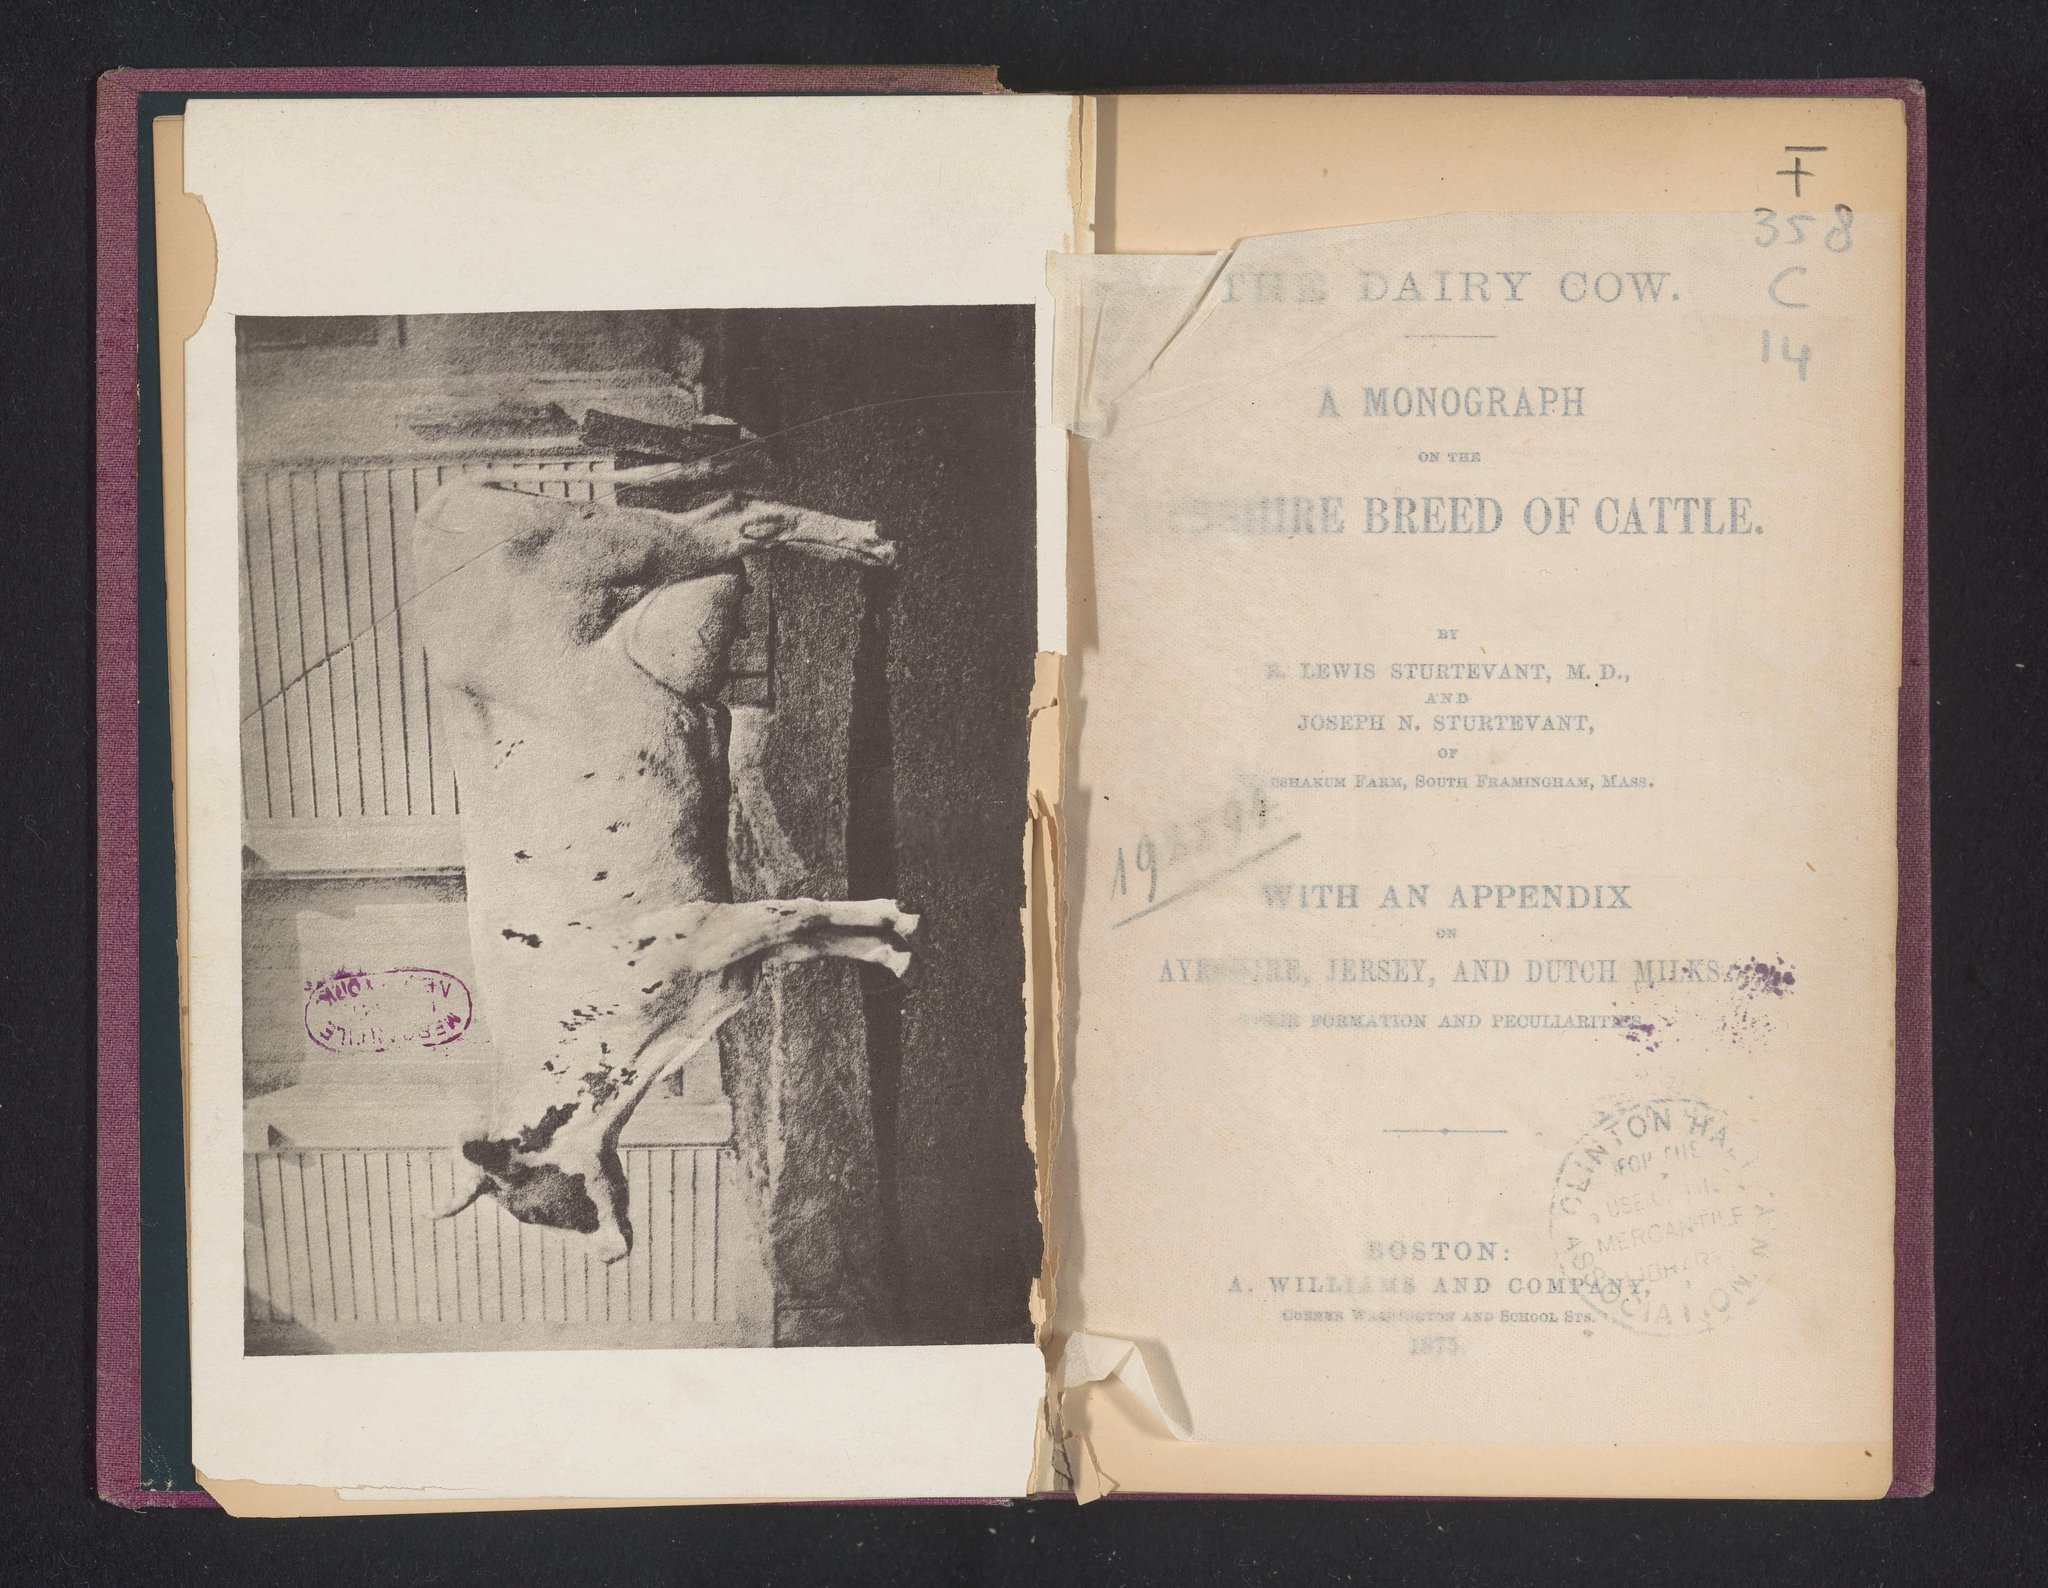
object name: photomechanical print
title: En profiel van een Ayrshire koe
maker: Anonymous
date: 1875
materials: paper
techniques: photograph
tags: bull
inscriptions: collector's mark: ‘Mercantile New York’